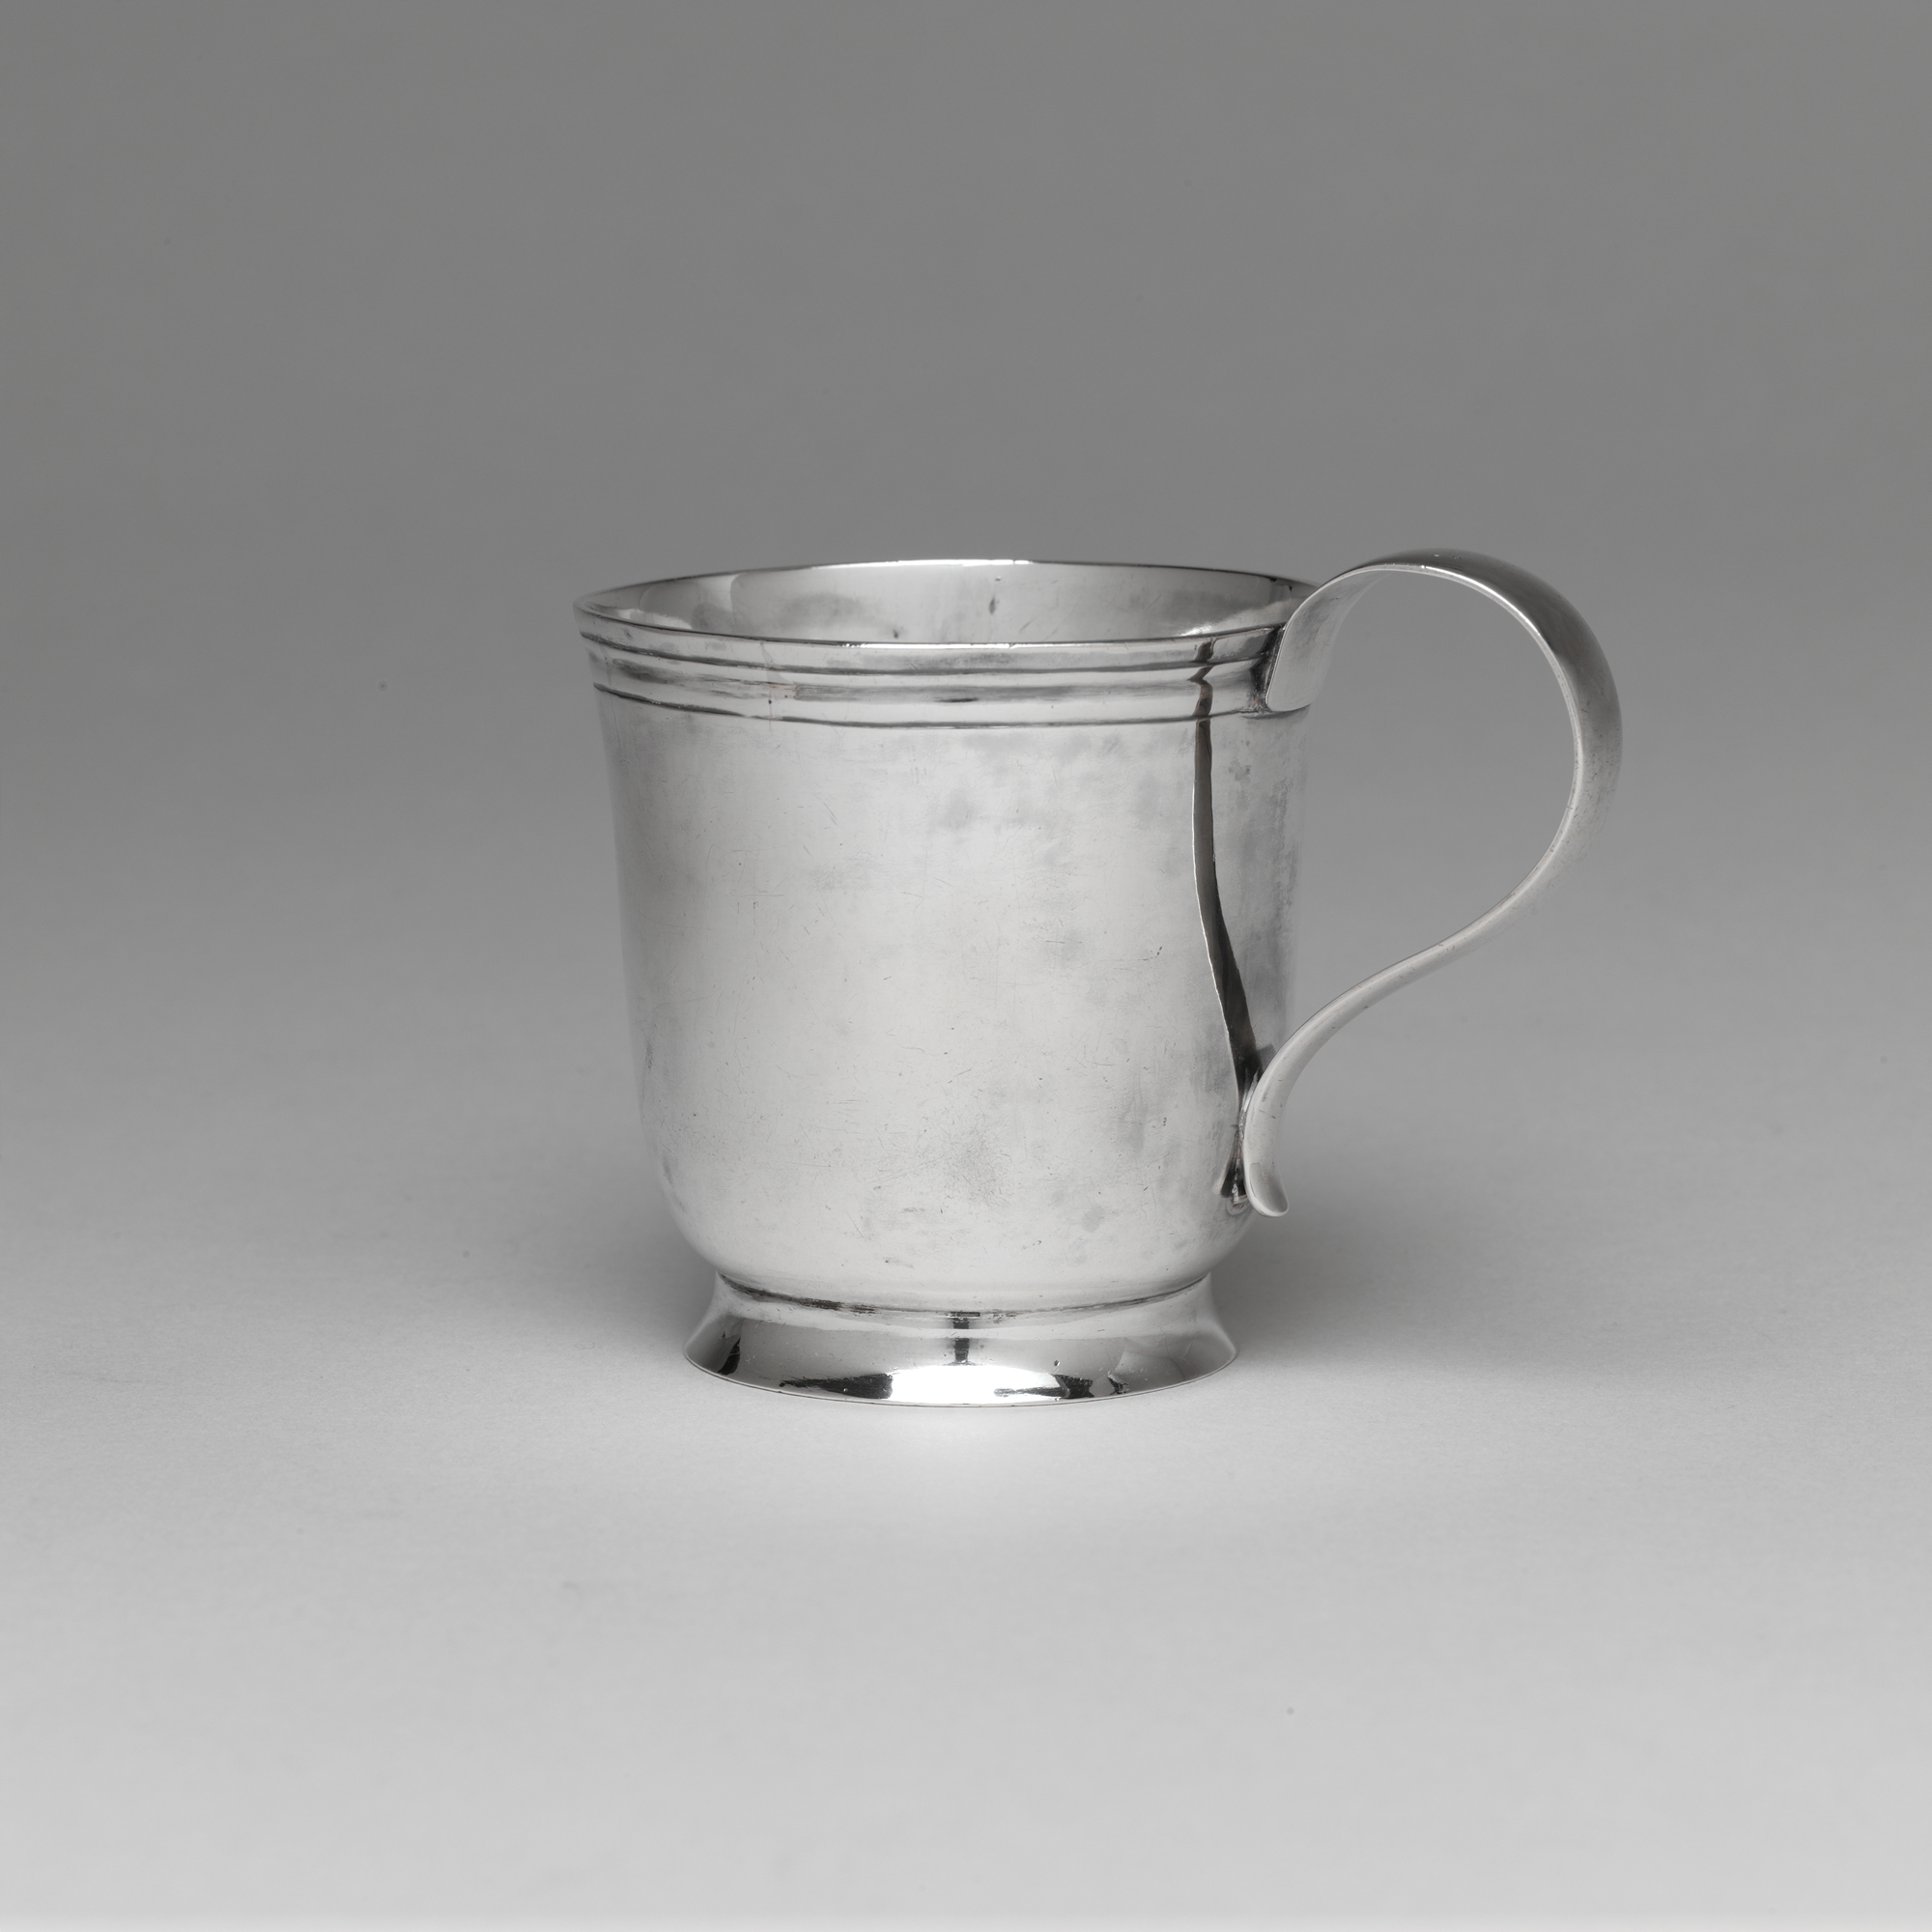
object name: cup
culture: american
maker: paul lambert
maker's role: maker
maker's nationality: american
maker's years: 1691-1749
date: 1729-1749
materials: silver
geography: canada